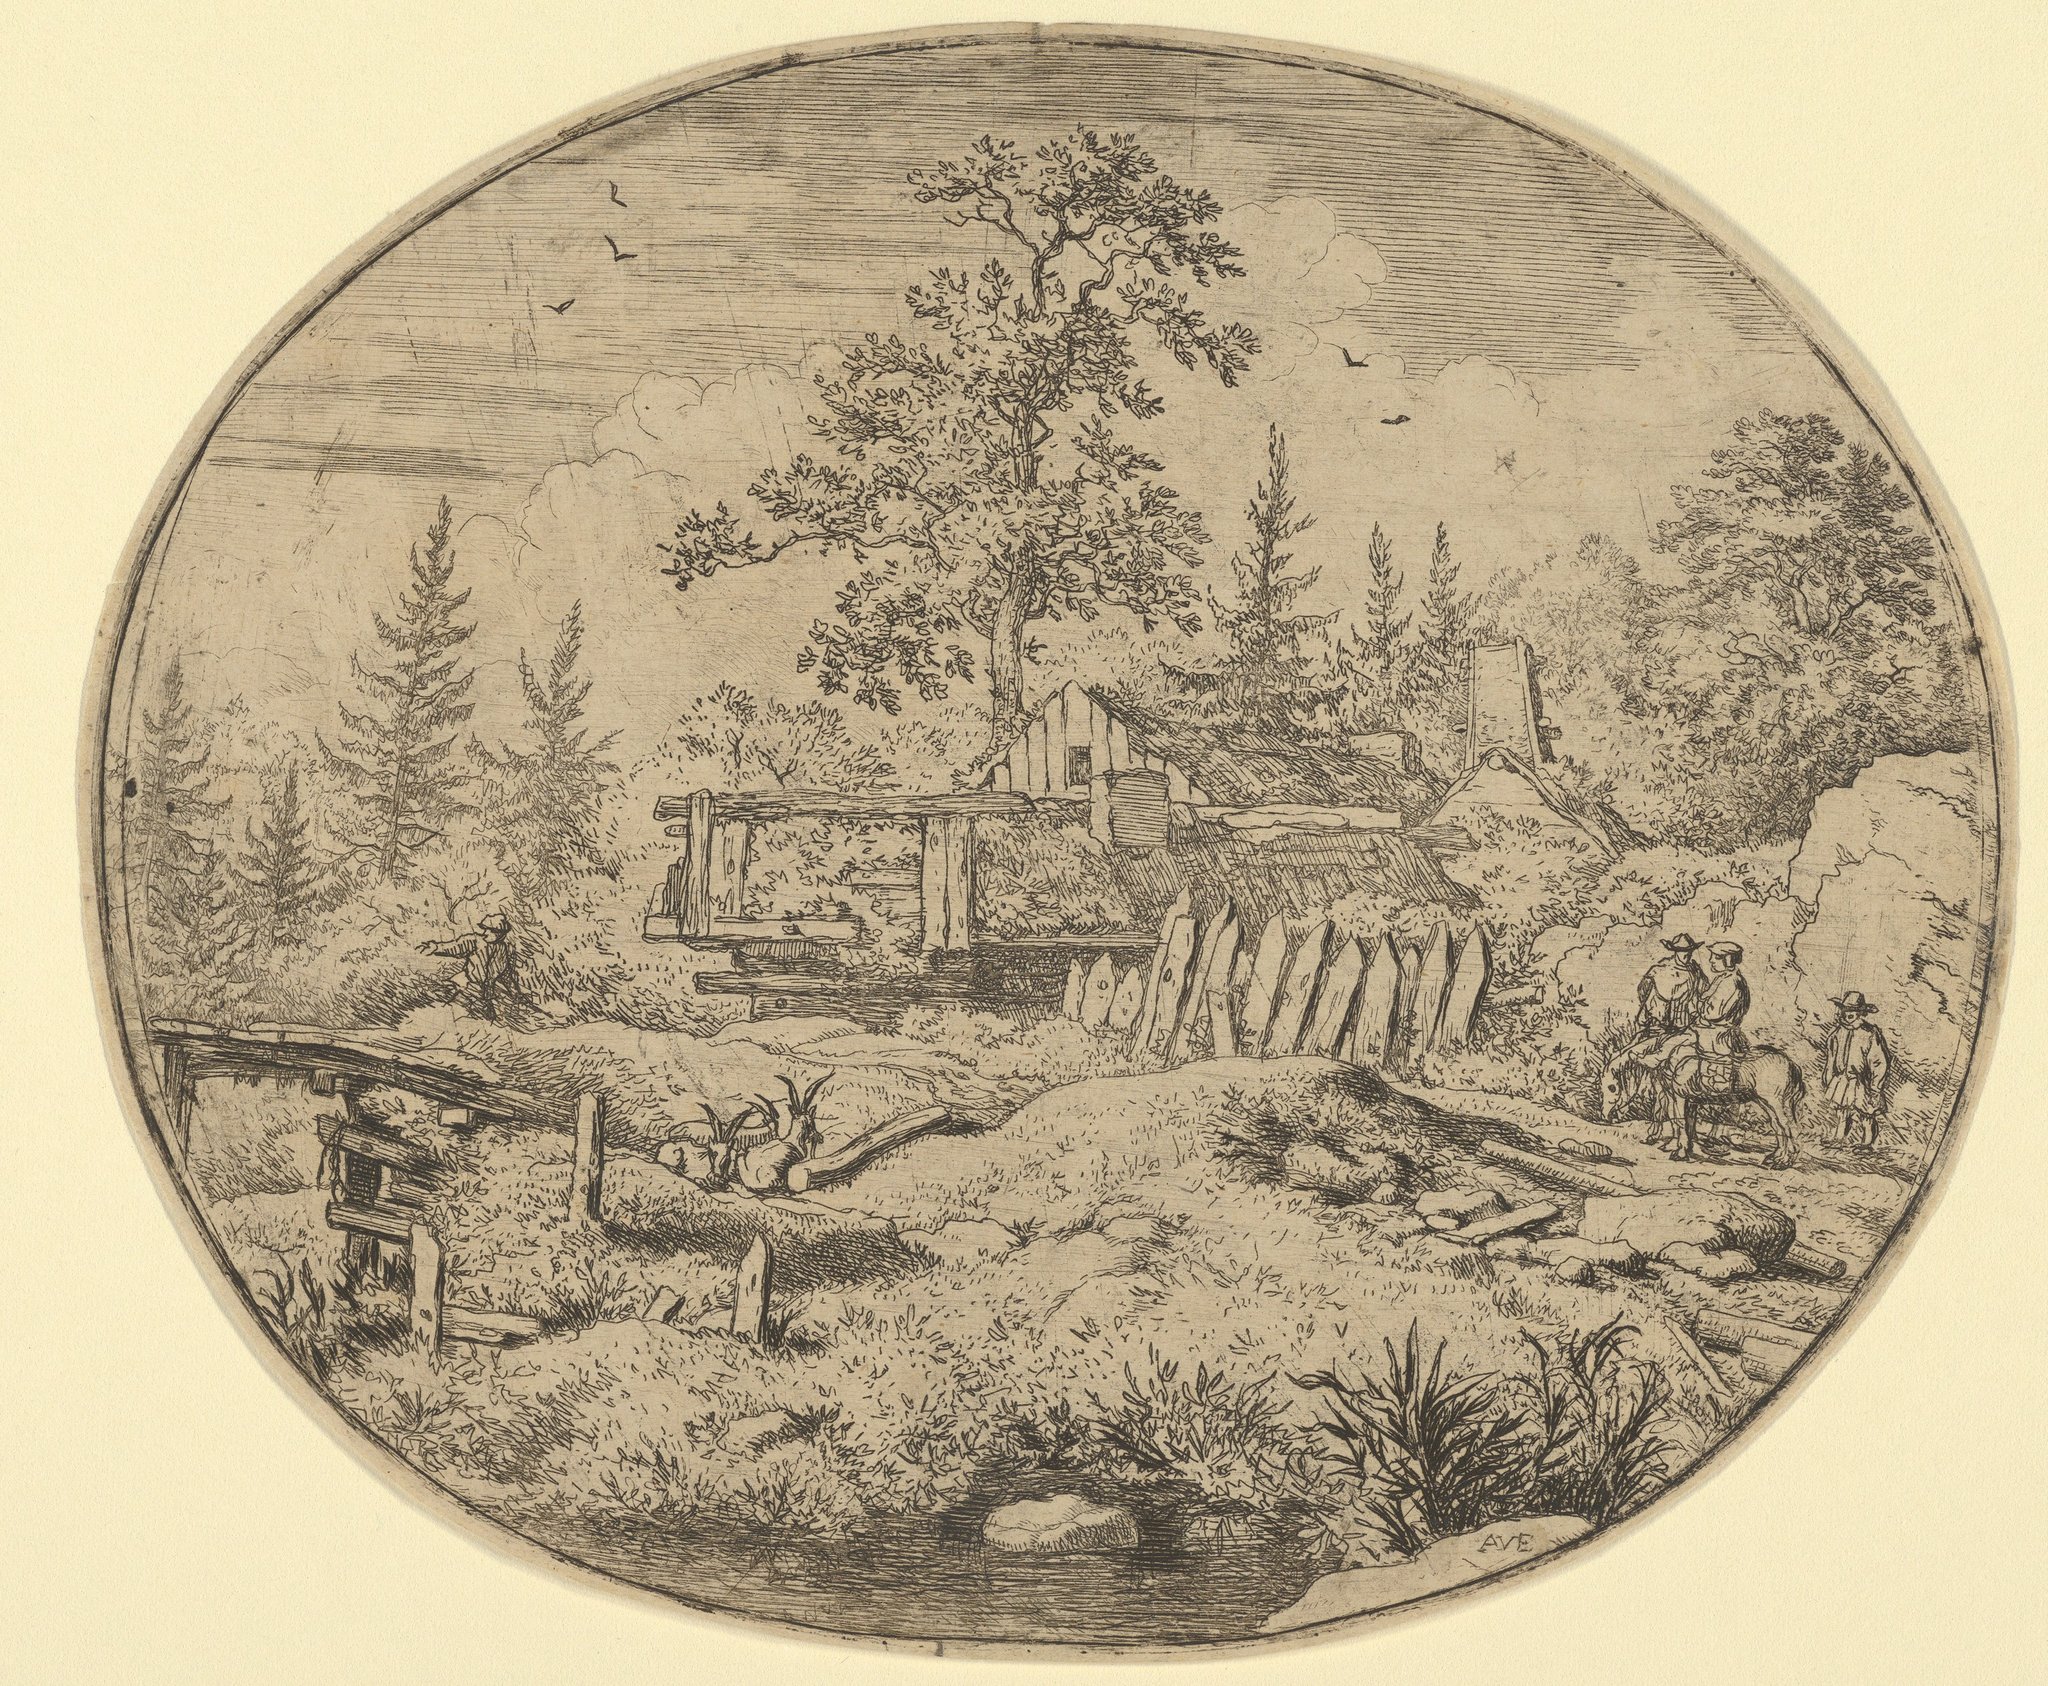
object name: print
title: The Landscape with the Wooden Bridge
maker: allart van everdingen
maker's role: artist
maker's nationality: dutch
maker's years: 1621-1675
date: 1621-1675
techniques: engraving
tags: bridges,landscapes,trees